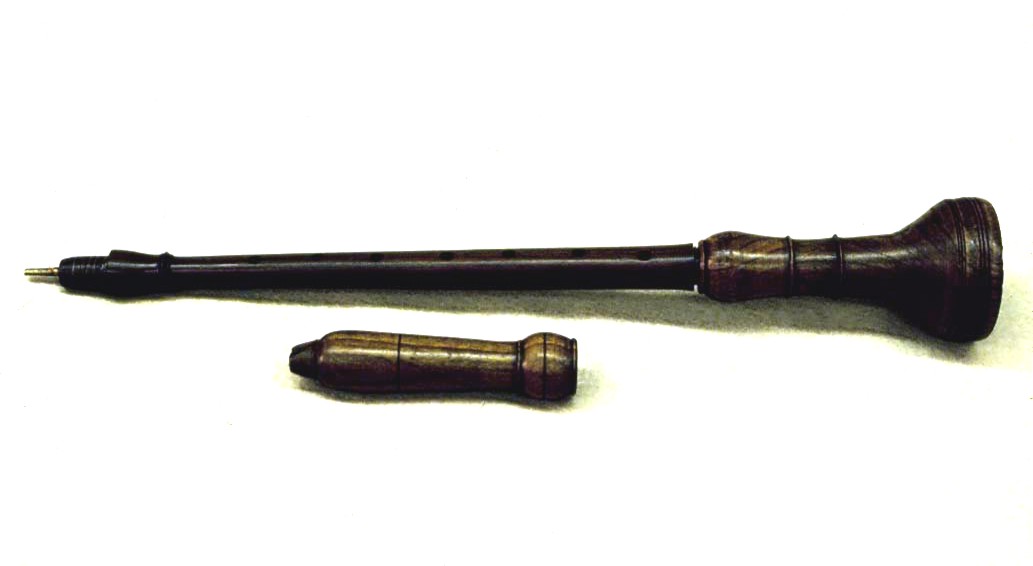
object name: hautbois de poitou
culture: french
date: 1800-1875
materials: wood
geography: france